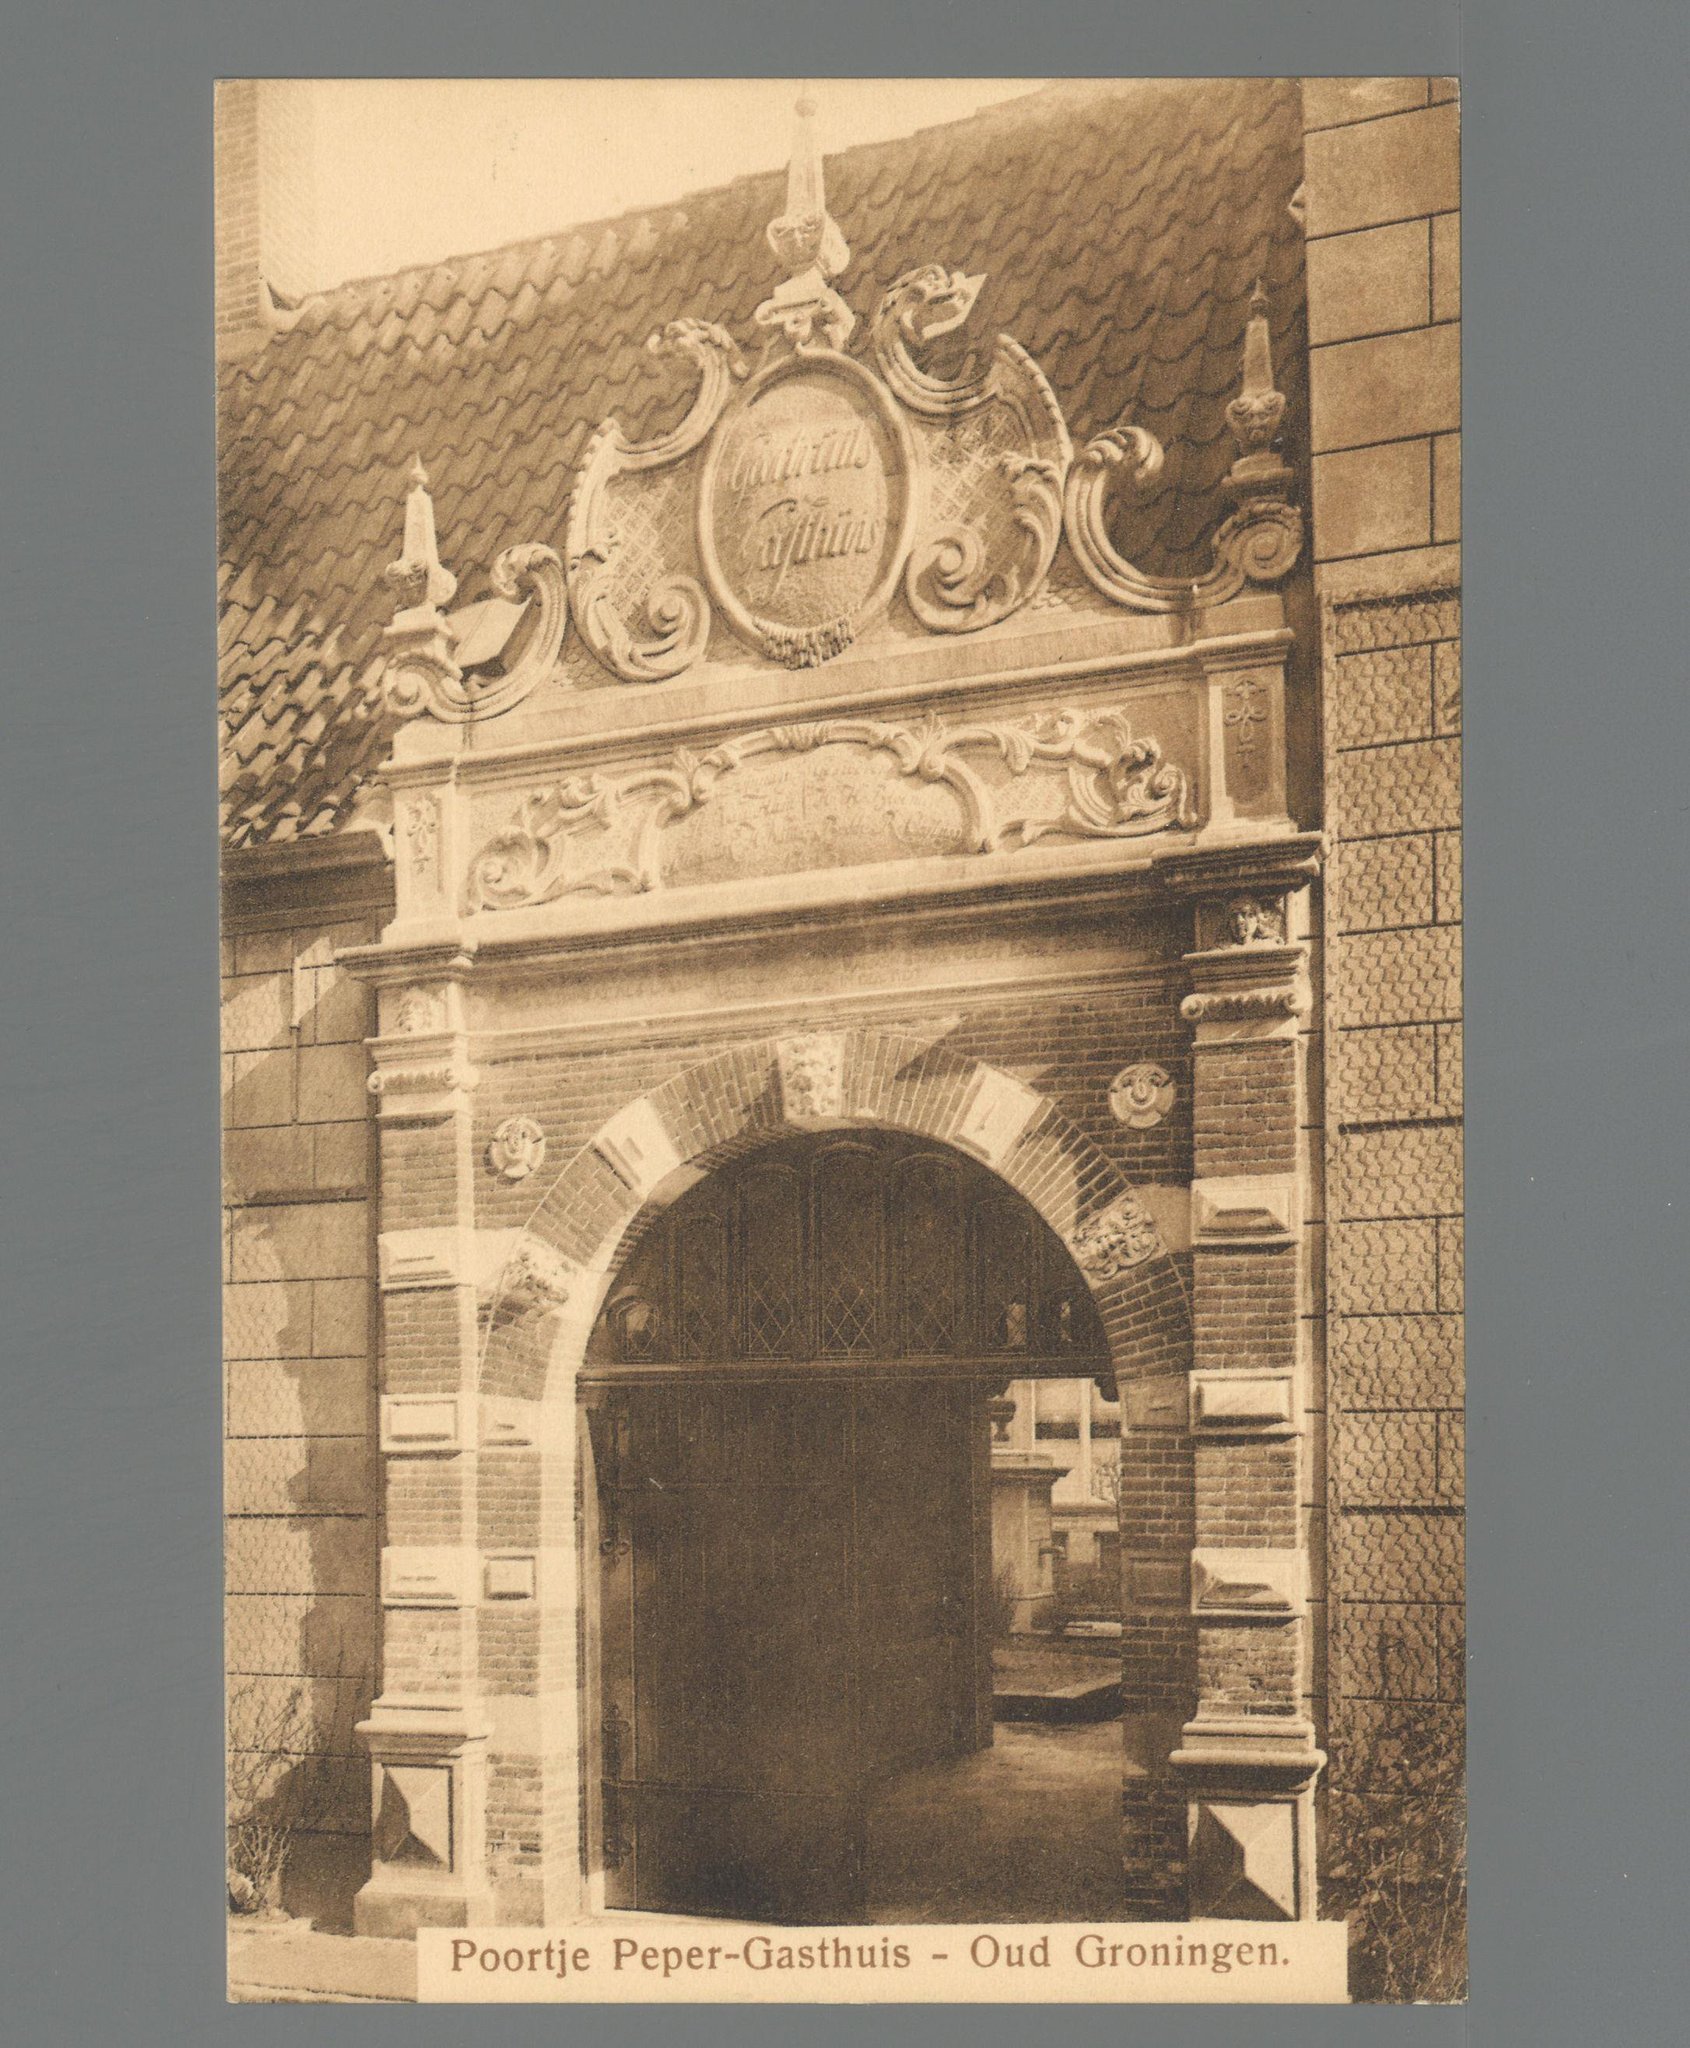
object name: ansichtkaart, prentbriefkaart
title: Poortje Peper-Gasthuis - Oud Groningen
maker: Anonymous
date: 1905-1930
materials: cardboard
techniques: photograph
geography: groningen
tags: gate, entrance